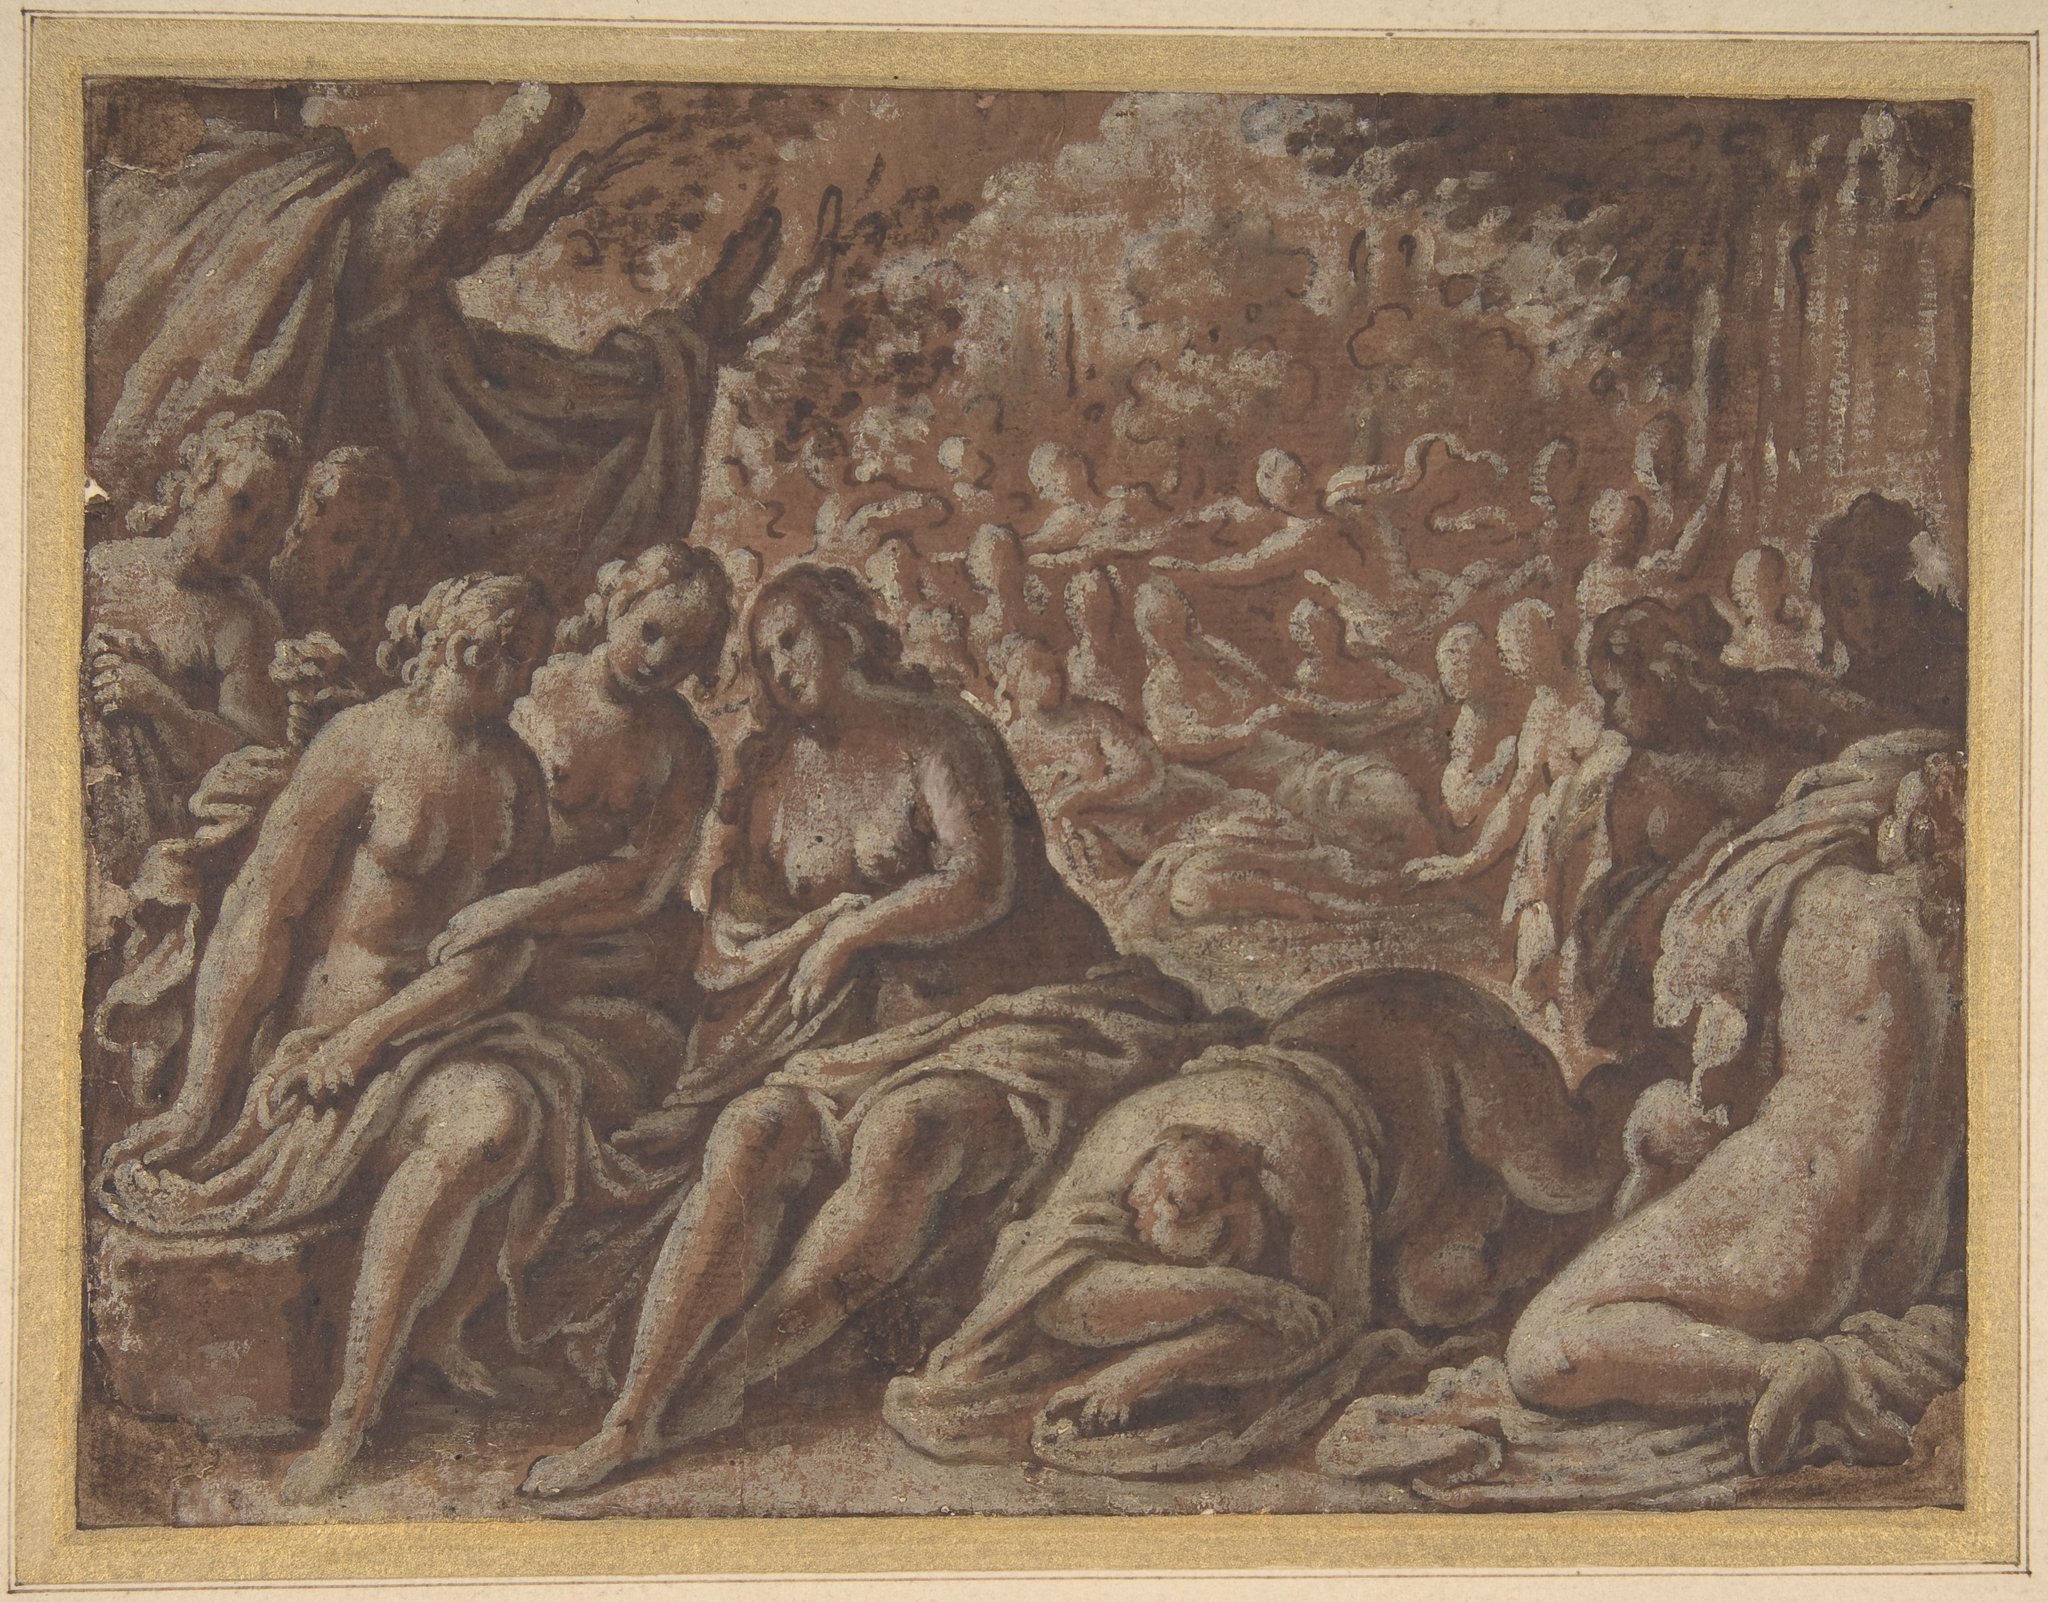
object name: drawing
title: Nymphs Bathing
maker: marcantonio bassetti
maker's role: artist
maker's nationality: italian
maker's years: 1586-1630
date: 1586-1630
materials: oil, paper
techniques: brush, heightening, wash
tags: female nudes,nymphs,bathing